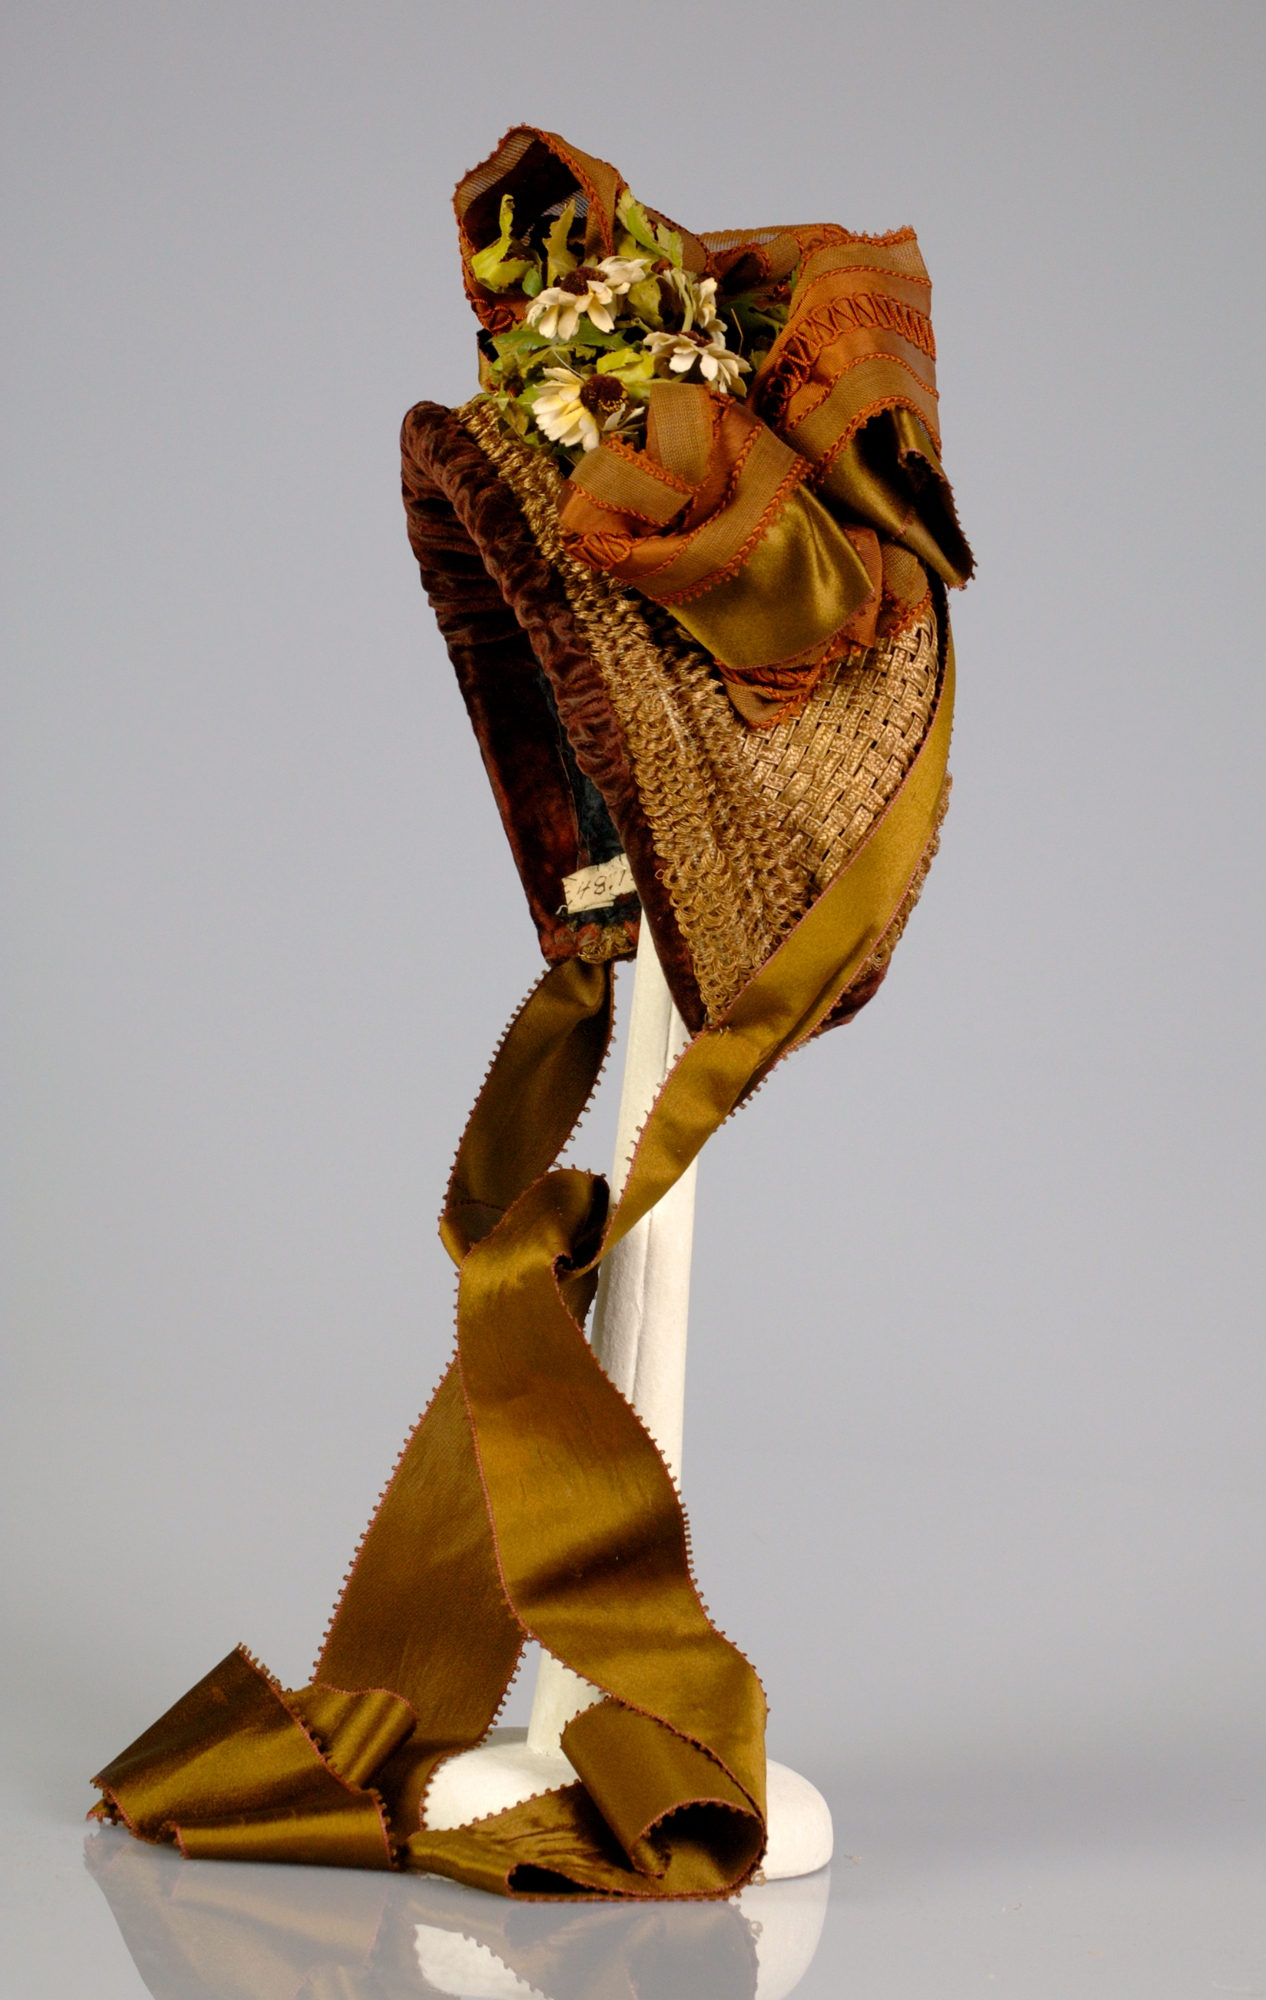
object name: bonnet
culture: american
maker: balch, price & company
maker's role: department store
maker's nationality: american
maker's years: 1869-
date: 1885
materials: cotton, silk, fiber